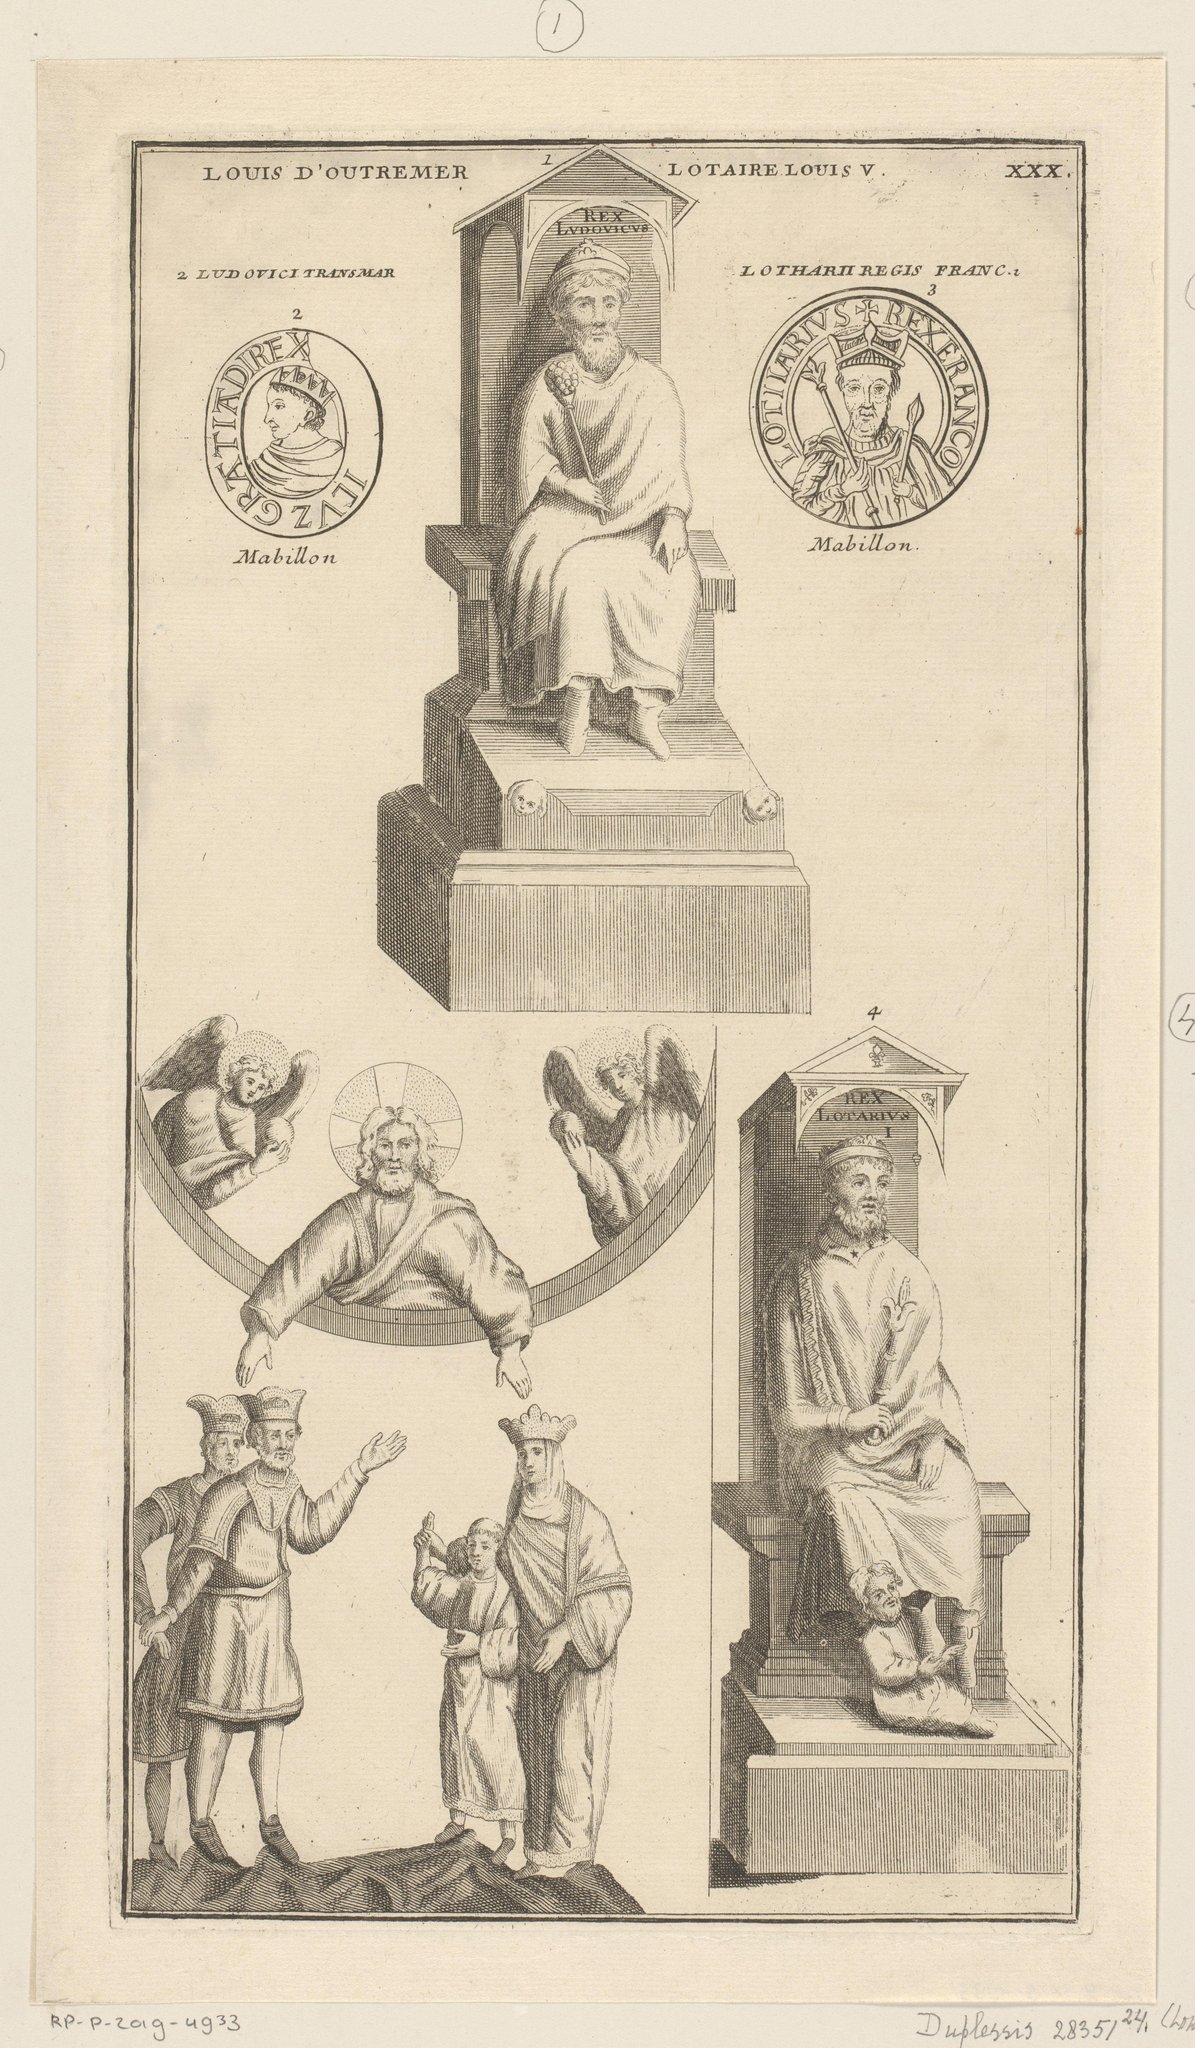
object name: print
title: Afbeeldingen van koning Lodewijk IV, Lotharius en Lodewijk V van Frankrijk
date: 1750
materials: paper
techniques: engraving, etching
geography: london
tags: historical persons, piece of sculpture, reproduction of a piece of sculpture, coin, king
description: Prent uit: Montfaucon, Bernard de. A collection of regal and ecclesiastical antiquities of France (...). Londen: William Innys, John en Paul Knapton, R. Manby en Henry Shute Cox, 1750, dl. 1. Prent voor het eerst, met andere nummering, verschenen in: Montfaucon, Bernard de. Les monumens de la Monarchie Françoise (...). Parijs: Julien-Michel Gandouin en Pierre-François Giffart, 1729-1733.